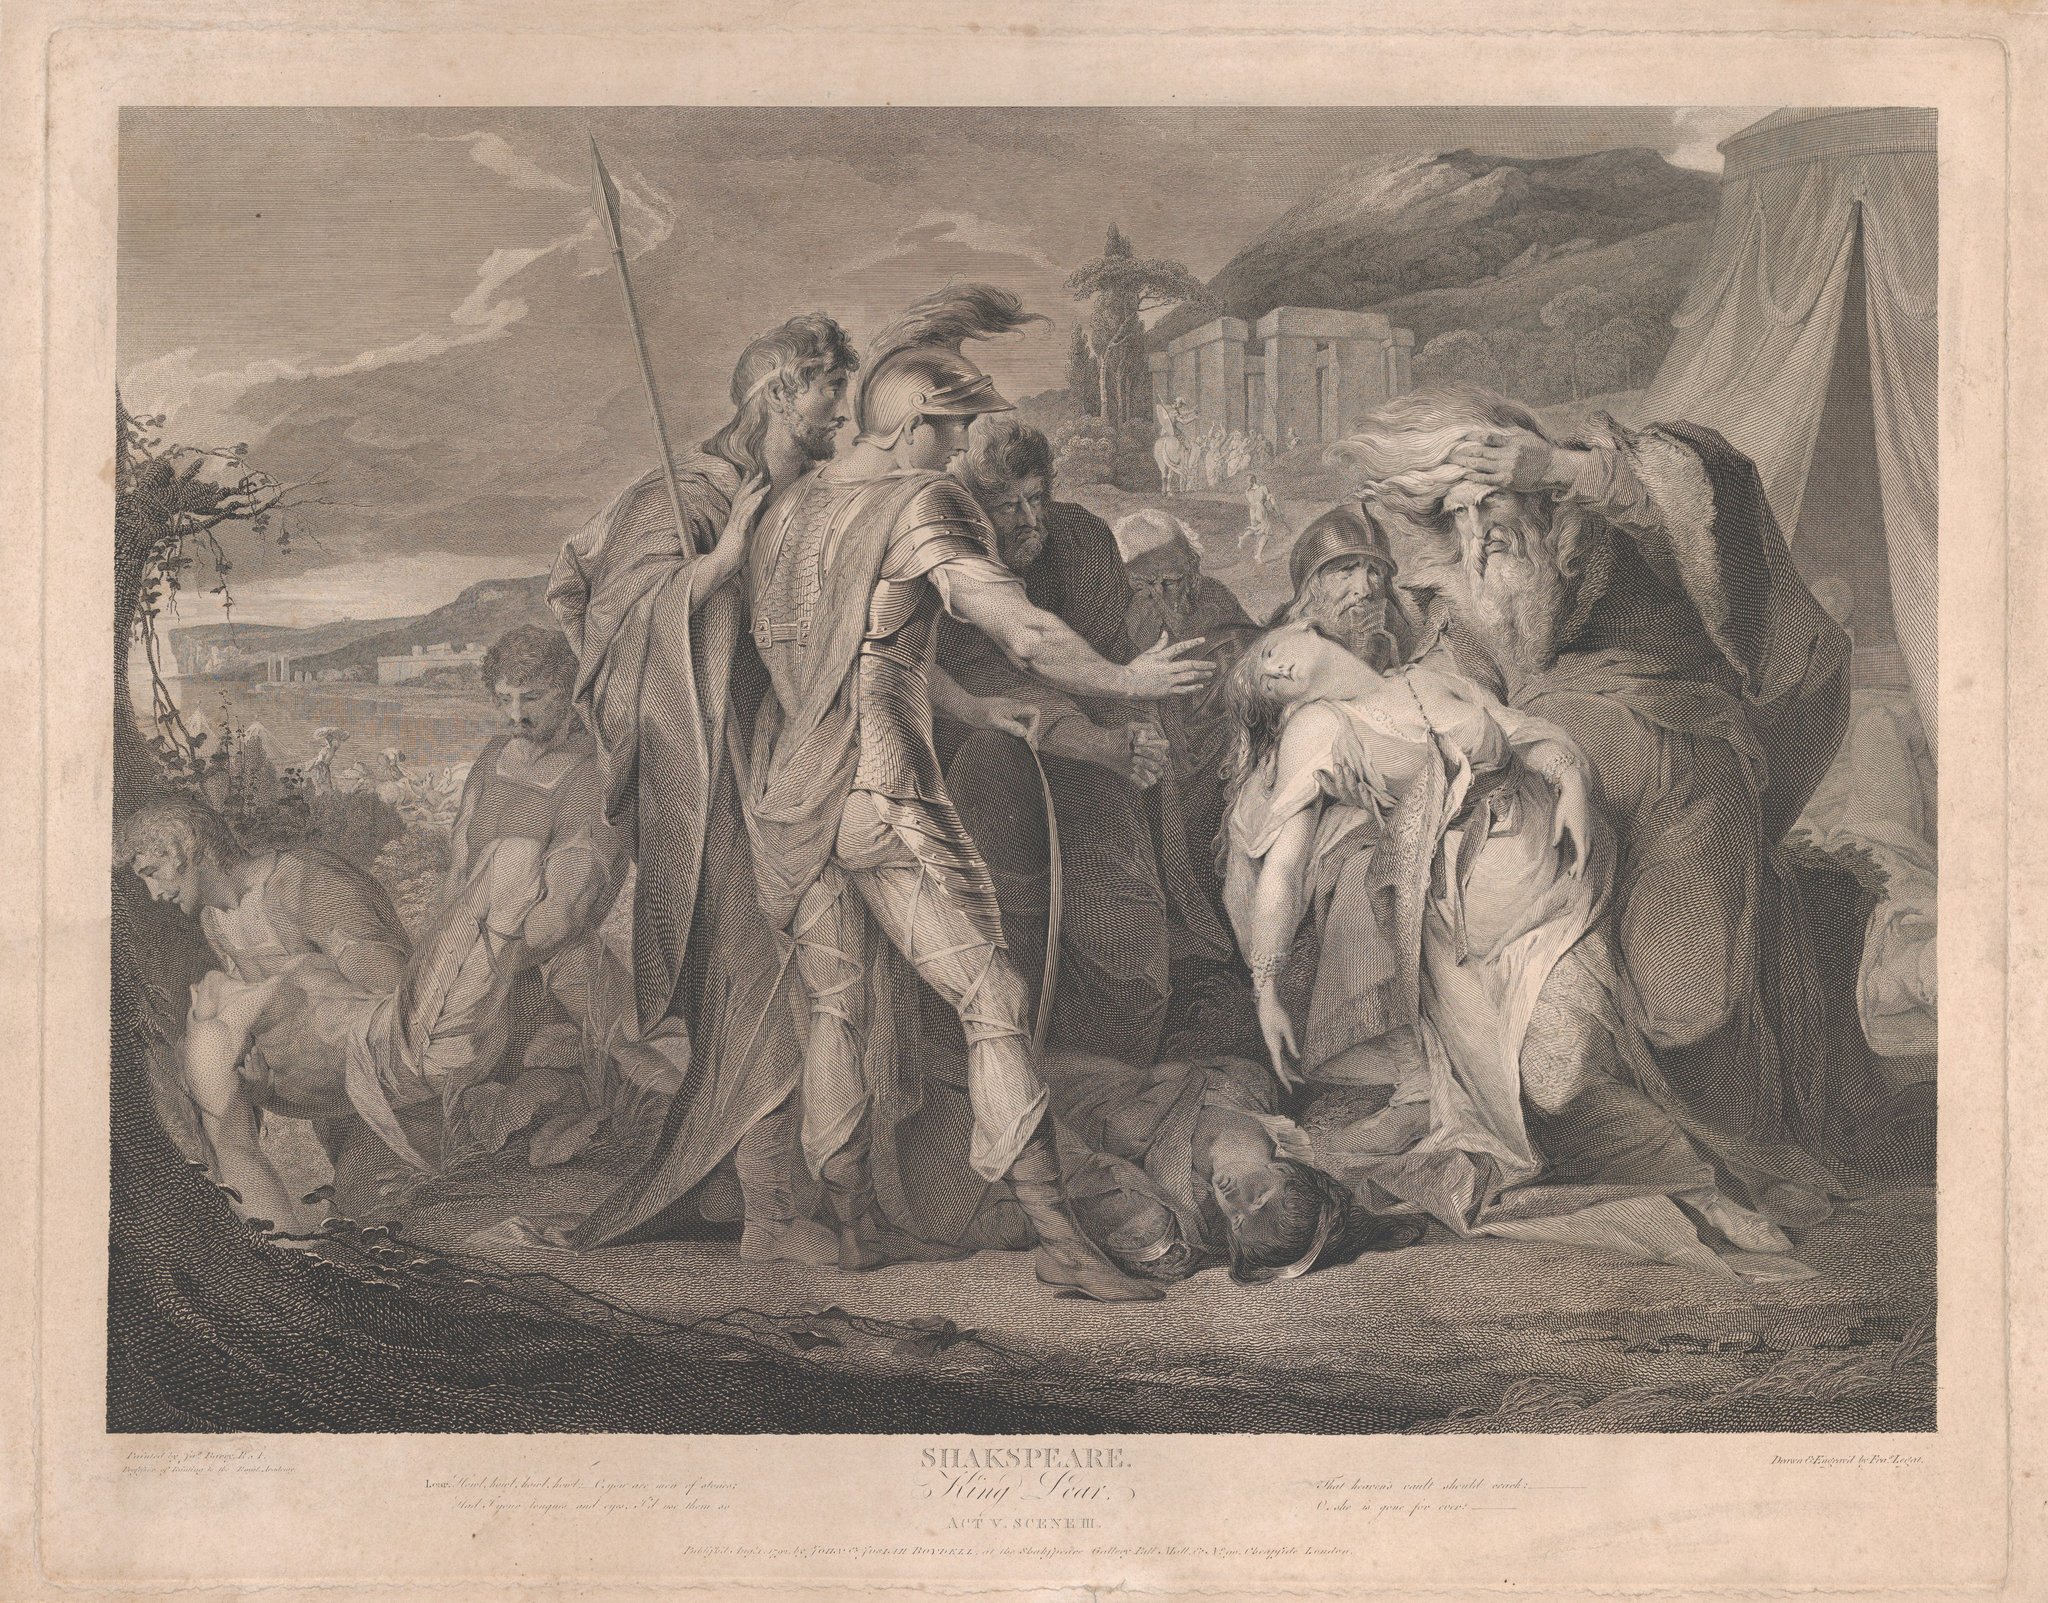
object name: print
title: King Lear Weeping Over the Body of Cordelia (Shakespeare, King Lear, Act 5, Scene 3)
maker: francis legat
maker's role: engraver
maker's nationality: british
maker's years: 1755-1809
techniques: engraving, etching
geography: england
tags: kings,shakespeare,men,women